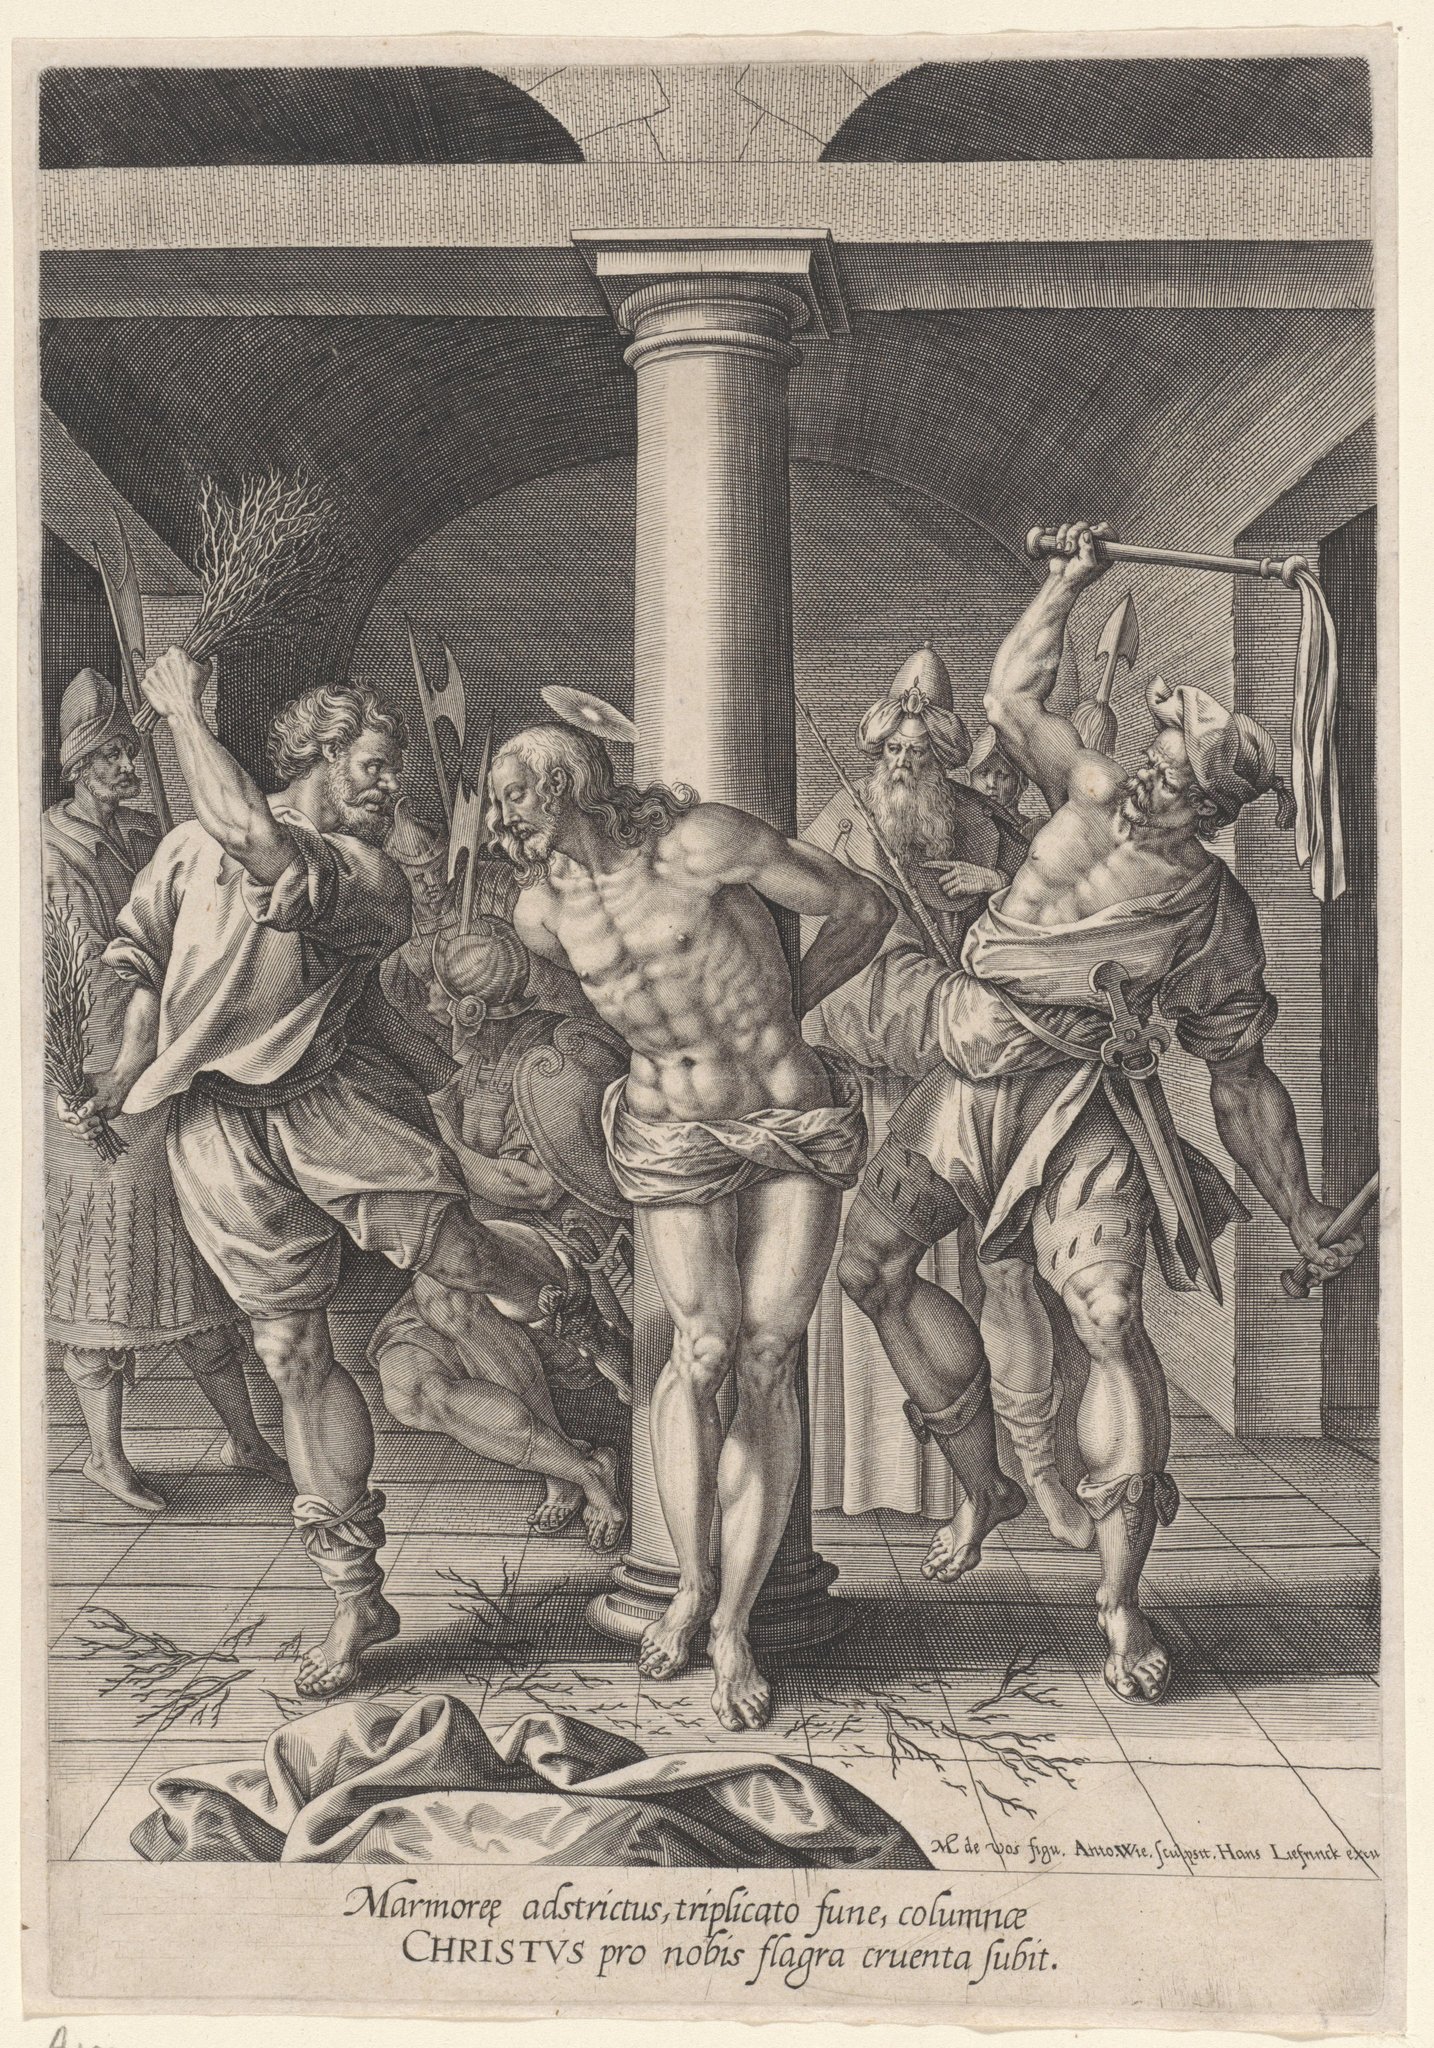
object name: print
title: Geseling van Christus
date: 1586-1590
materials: paper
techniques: engraving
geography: antwerp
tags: flagellation by soldiers, christ usually tied to a column (matthew 27:26; mark 15:15; john 19:1)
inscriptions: collector's mark: Lugt 2228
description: Christus, vastgebonden aan een pilaar, wordt door twee soldaten gegeseld. Pilatus kijkt toe vanaf de achtergrond. In de marge een tweeregelig onderschrift in het Latijn.